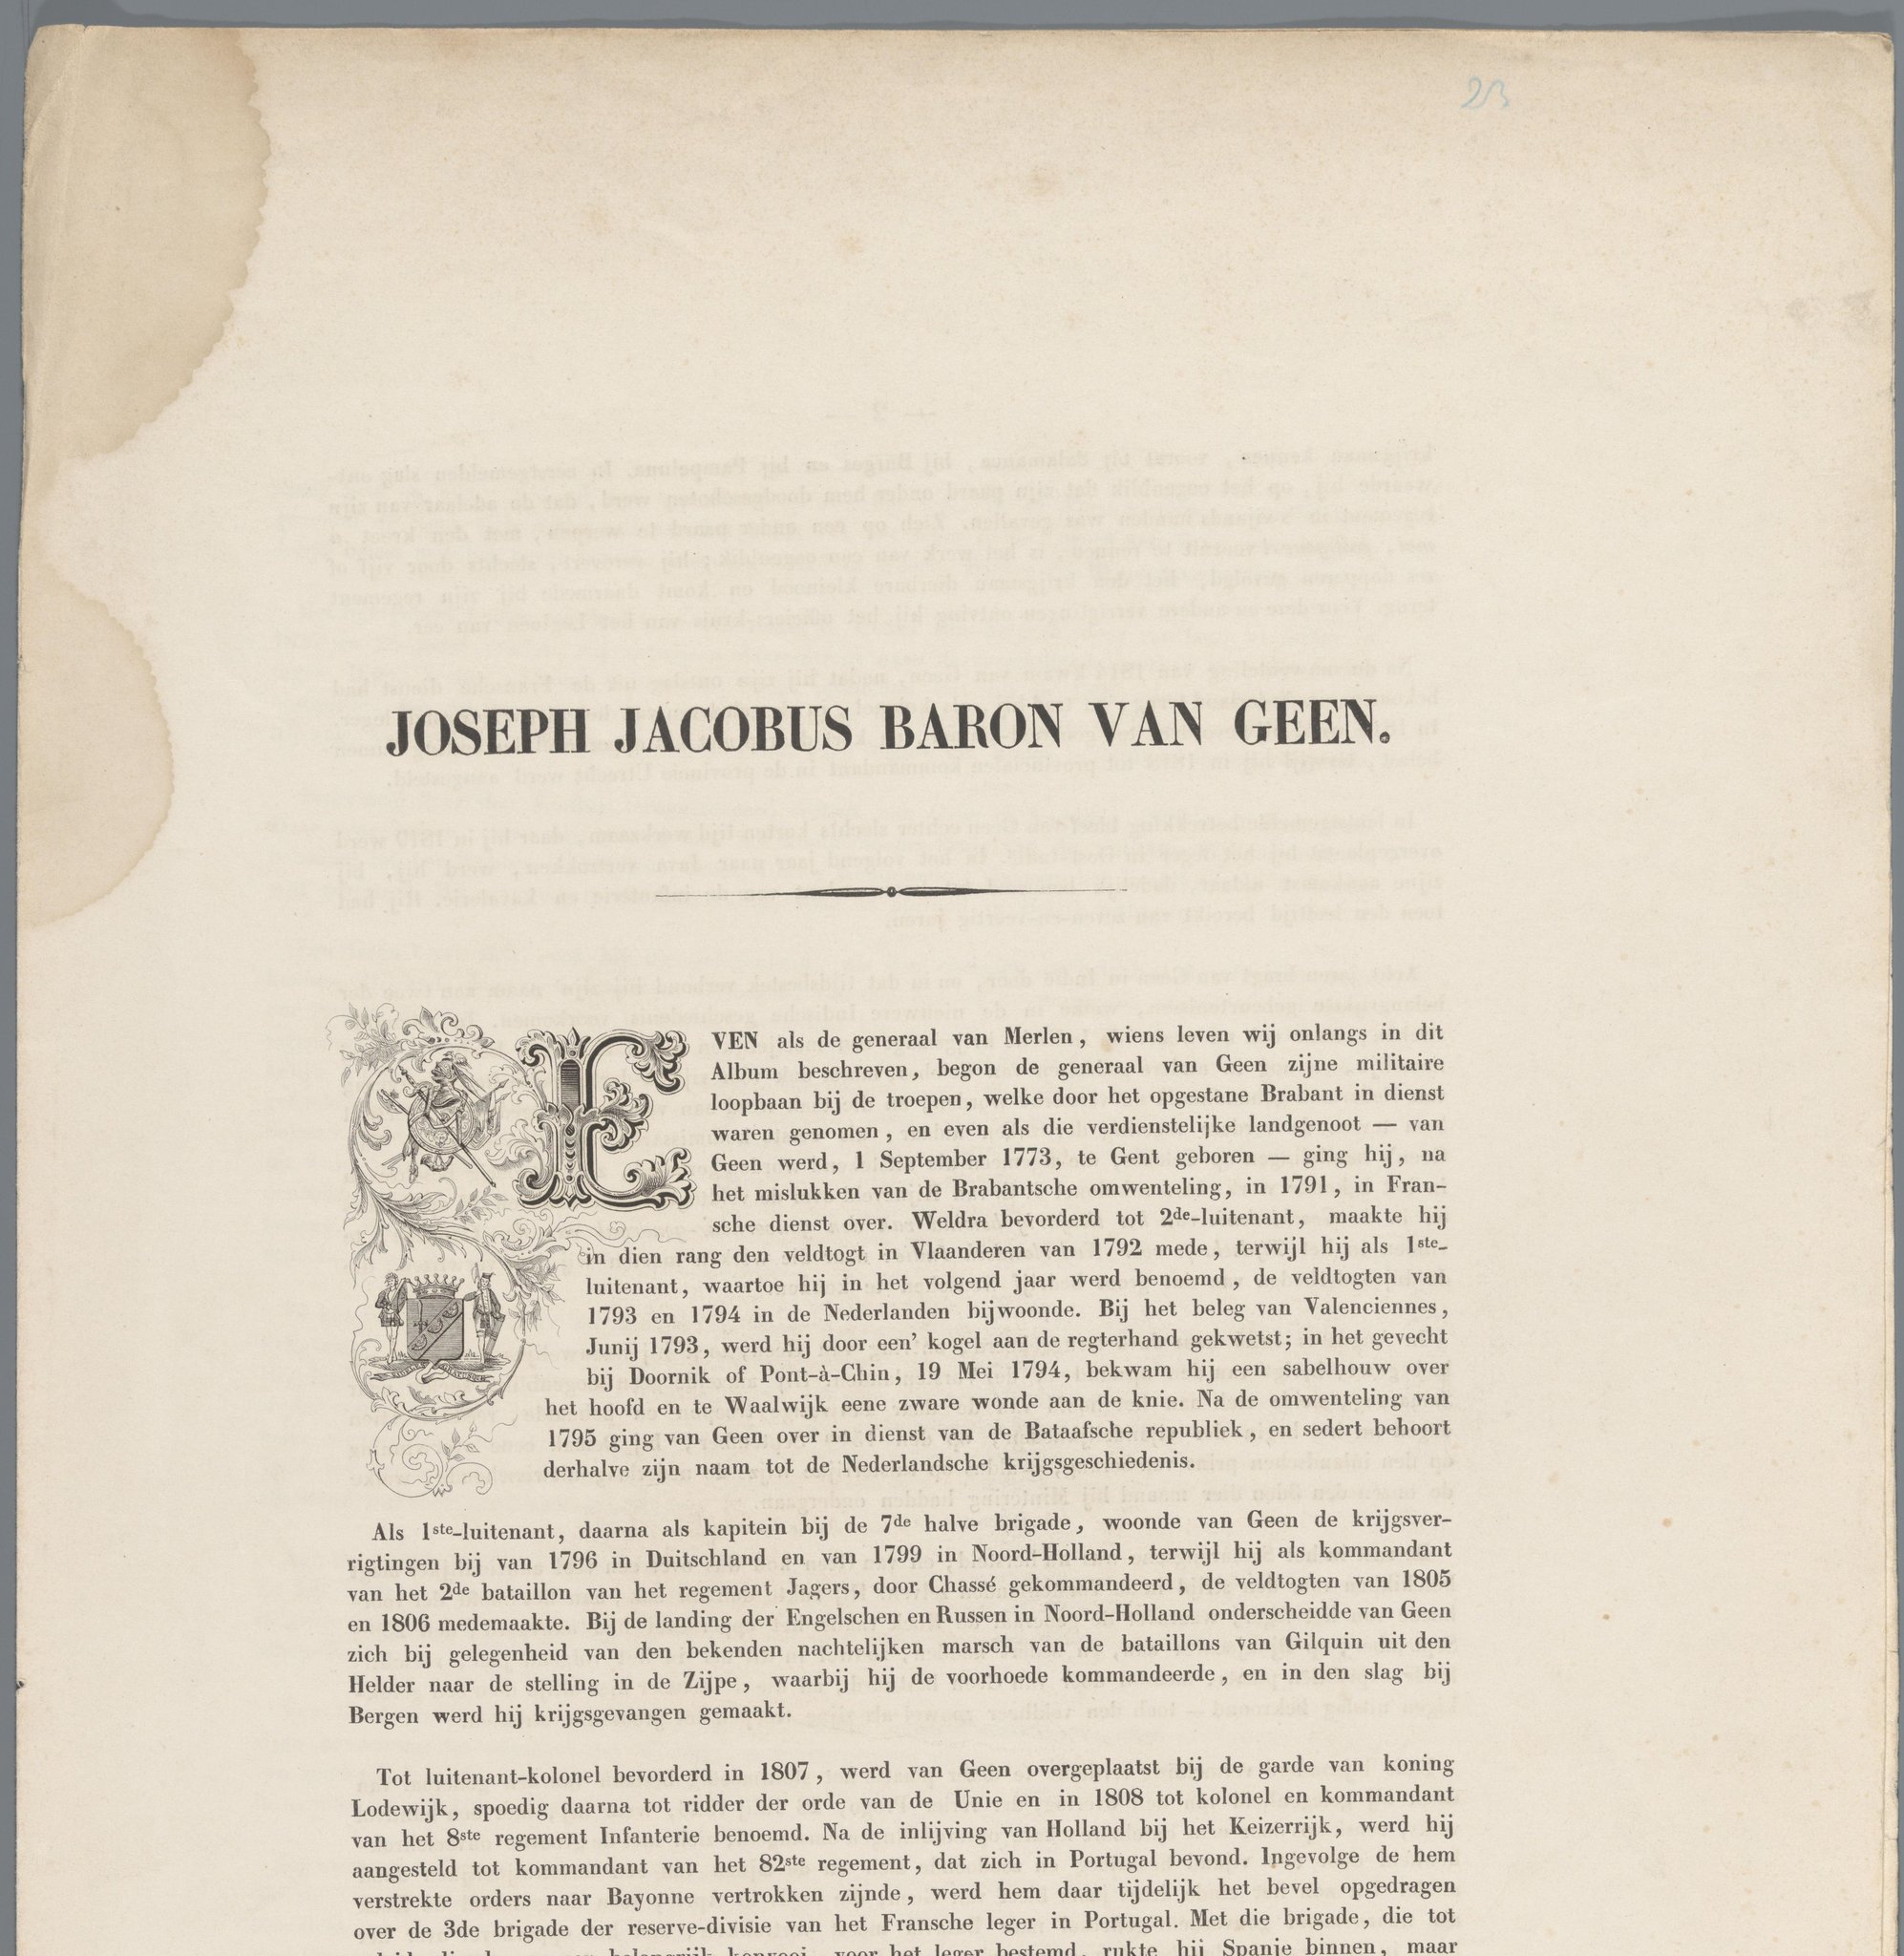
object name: leaflet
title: Joseph Jacobus Baron van Geen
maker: elias spanier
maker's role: print maker, printer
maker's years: 1821-1863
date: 1831-1863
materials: paper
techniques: printing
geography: the hague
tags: ghent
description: Dubbelgevouwen blad papier, 3 genummerde en bedrukte pp., met op voorp. versierde E met wapenschild. Levenbeschrijving van J. J. Baron van Geen. Opmerking: Hoort bij inv. nr. NG-NM-10388-23-a (portret).